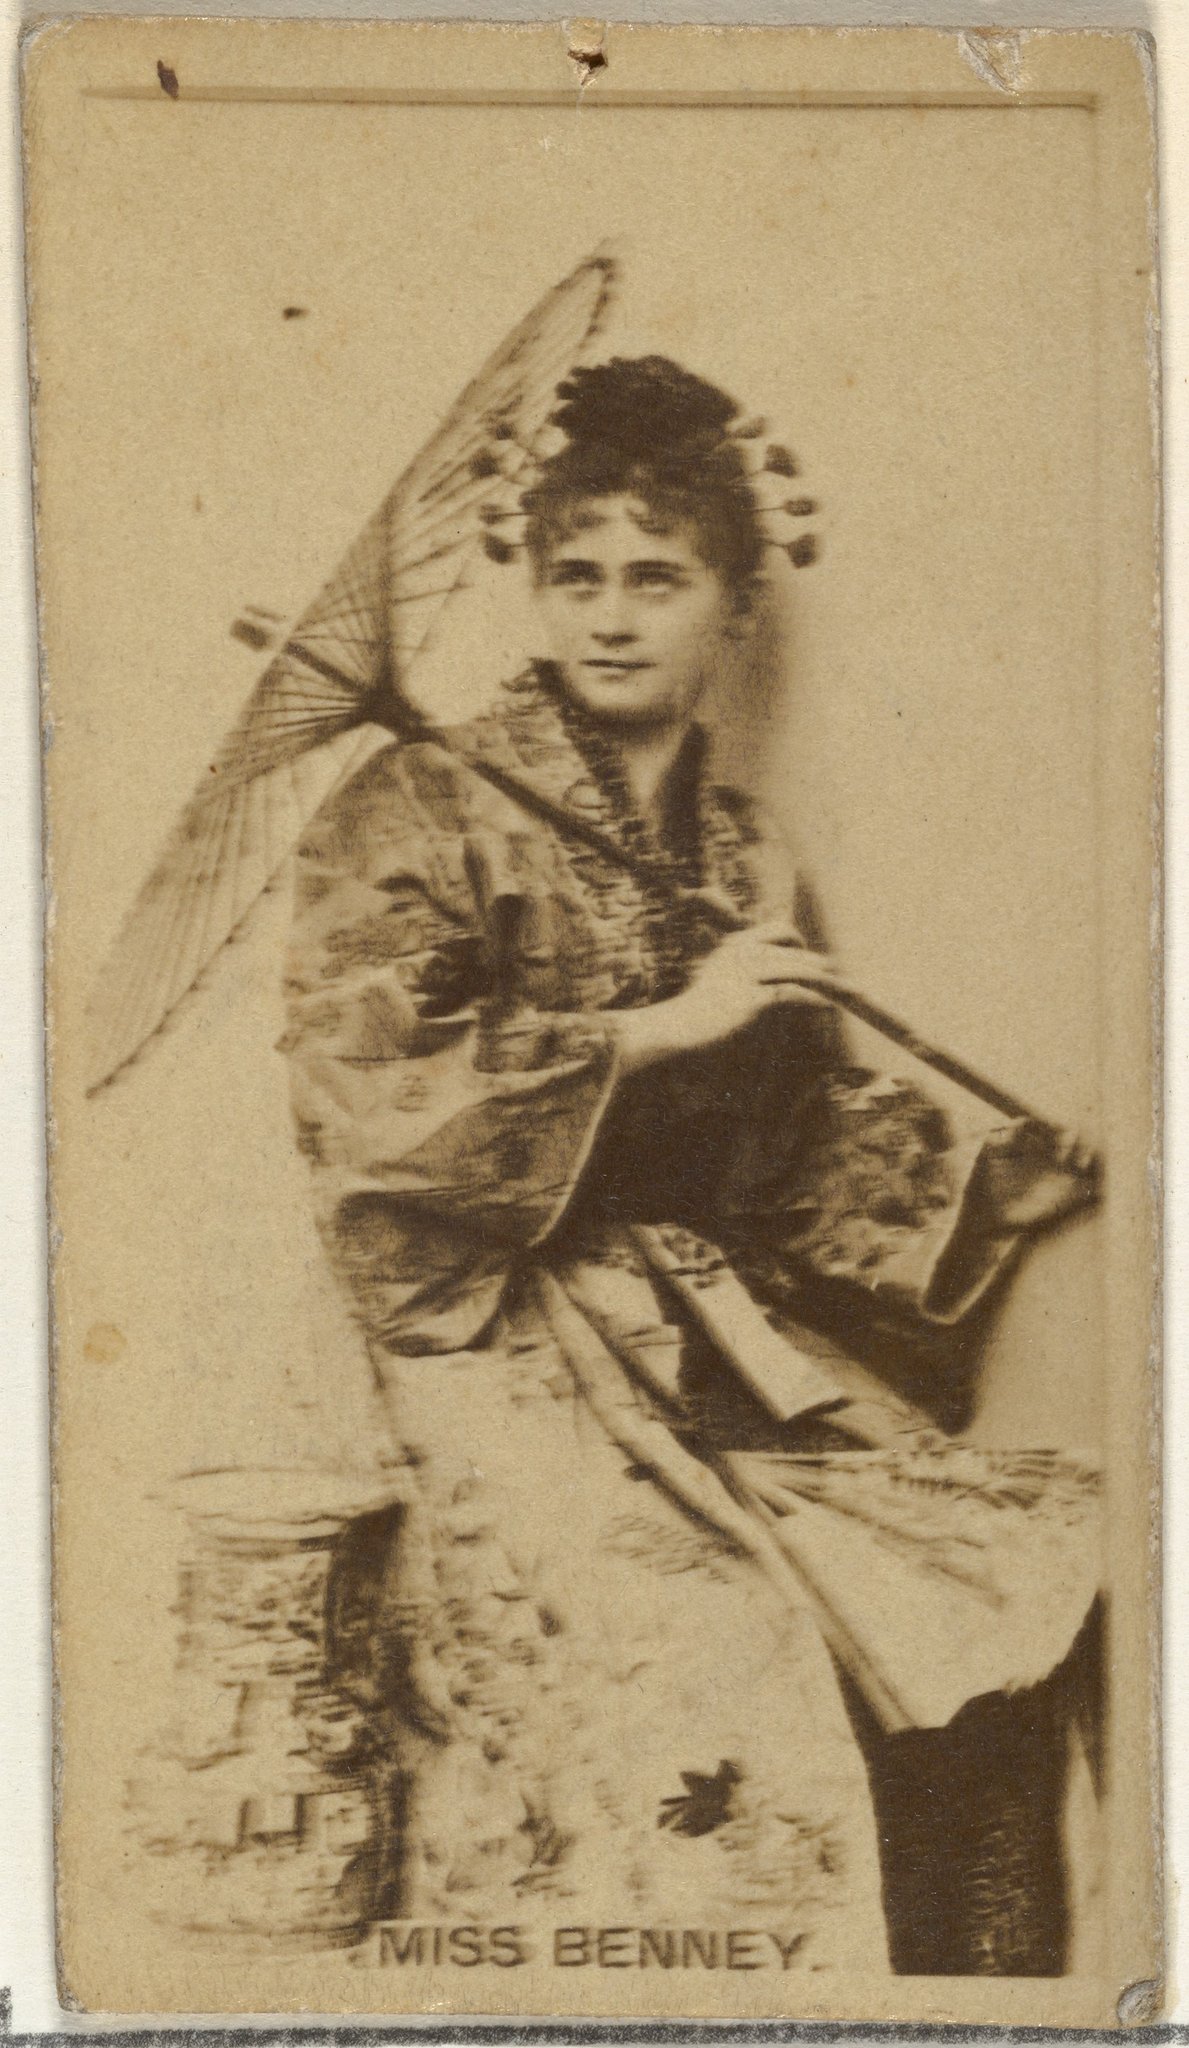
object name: photograph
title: Miss Benney, from the Actors and Actresses series (N145-8) issued by Duke Sons & Co. to promote Duke Cigarettes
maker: w. duke, sons & co.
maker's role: publisher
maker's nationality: american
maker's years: 1870-1920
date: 1891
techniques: albumen silver print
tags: portraits,women,actresses